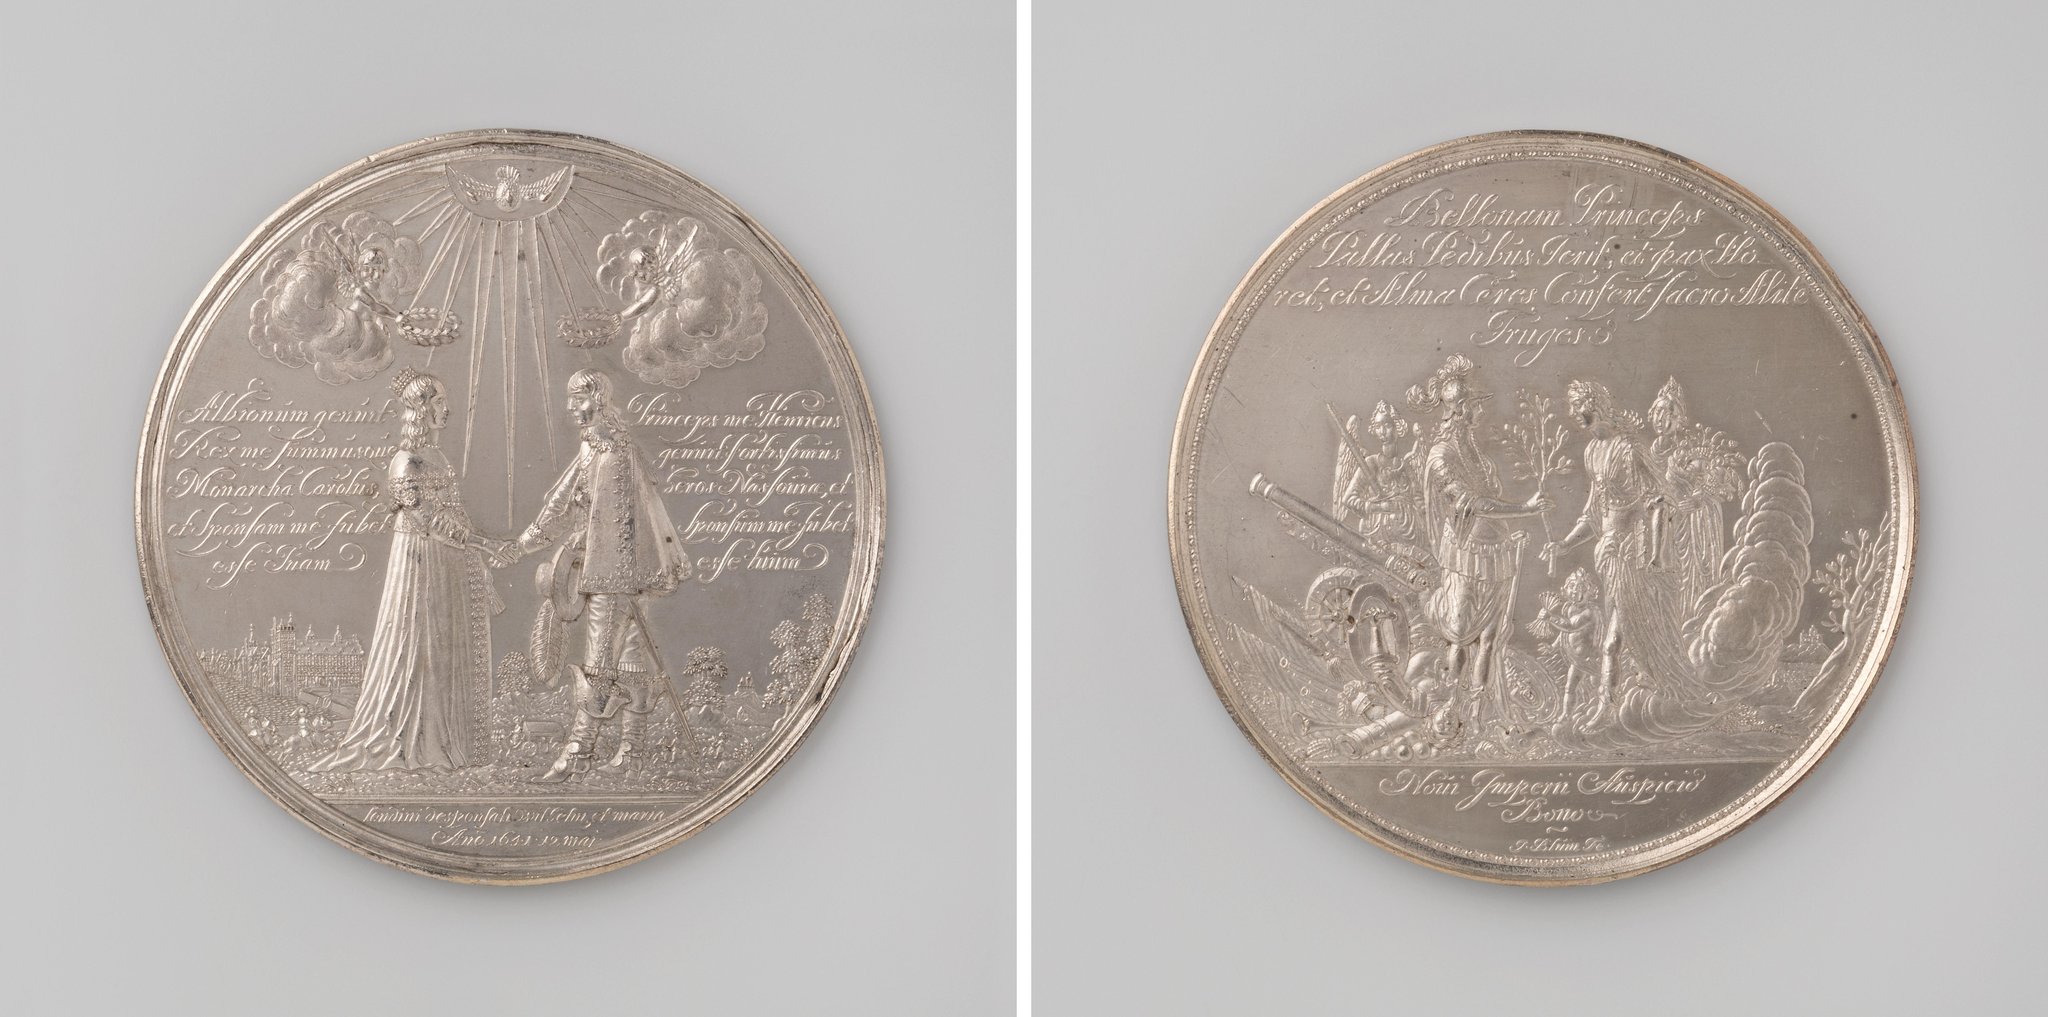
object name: history medal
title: Huwelijk van prins Willem II met Maria van Engeland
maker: johann blum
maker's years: 1599-1668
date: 1641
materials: silver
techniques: striking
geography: bremen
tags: william ii (prince of orange), mary henrietta stuart